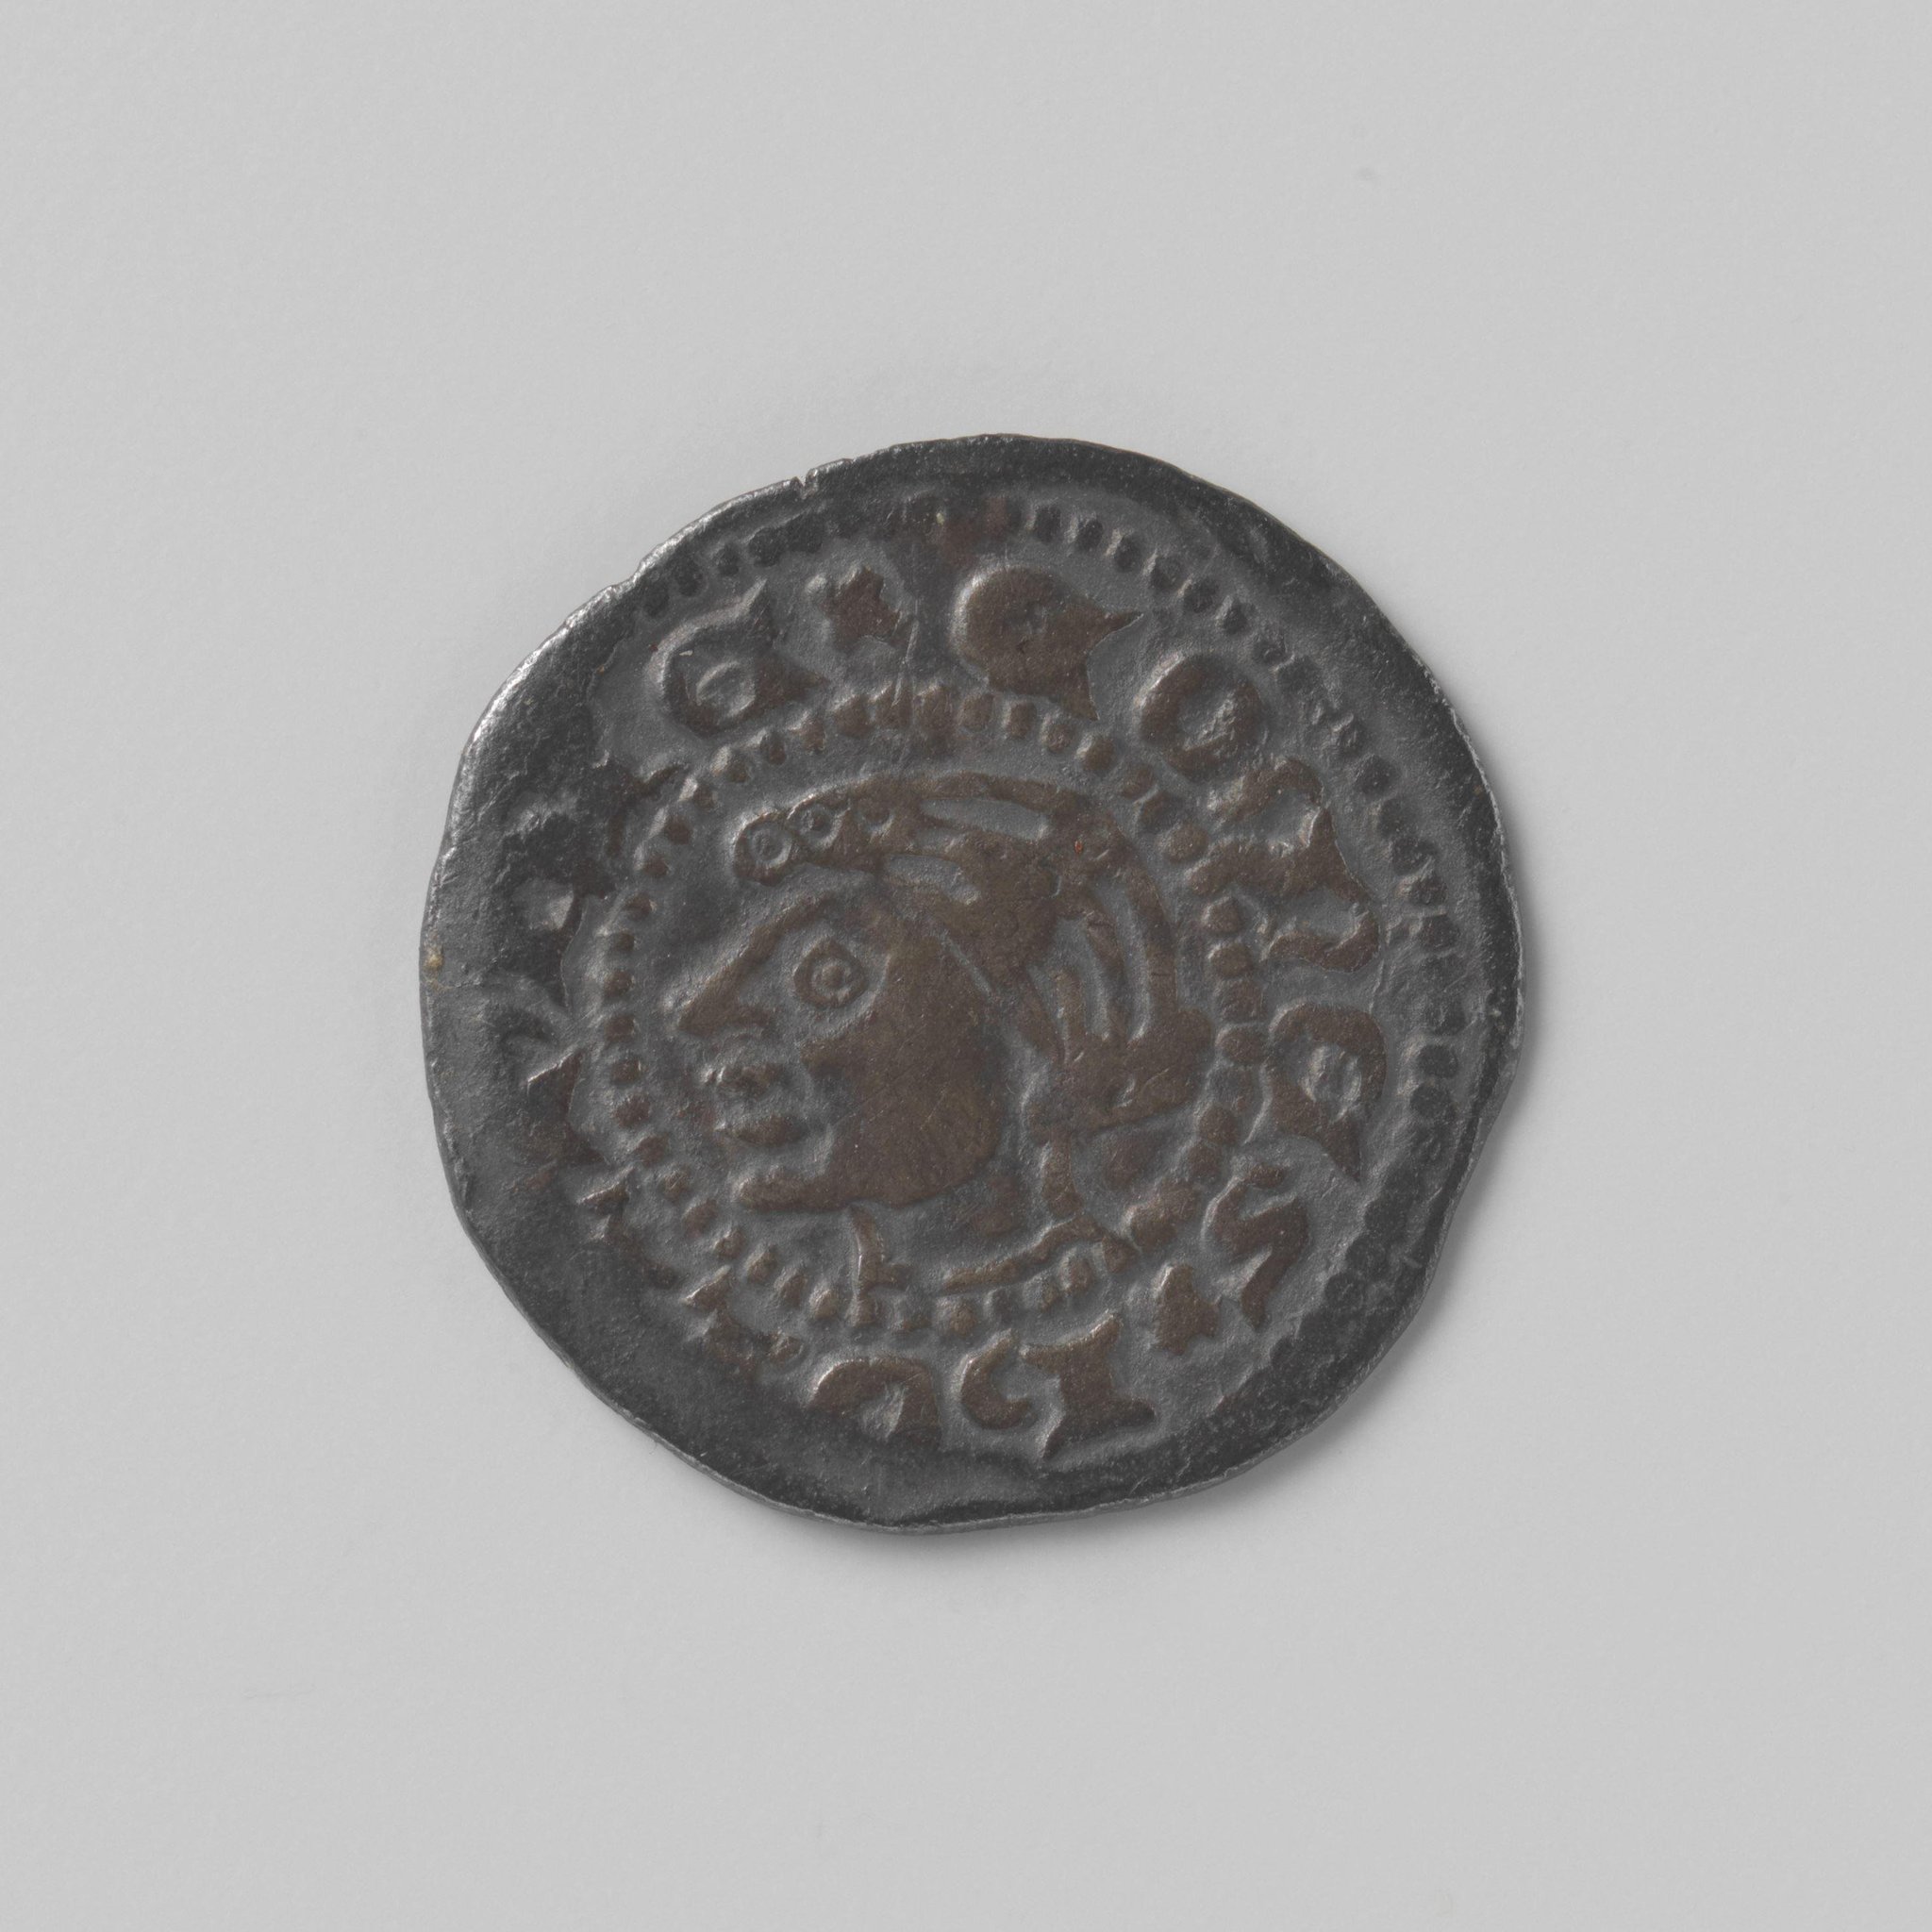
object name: penny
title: Holland, Floris V, penning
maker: floris v (graaf van holland en zeeland)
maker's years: 1254-1296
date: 1284-1286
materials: silver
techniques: striking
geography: dordrecht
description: Zilveren munt. Voorzijde: hoofd met gravenmuts naar links. Keerzijde: lang dubbellijnig kruis, in hoeken vijfpuntige spoorradertjes.